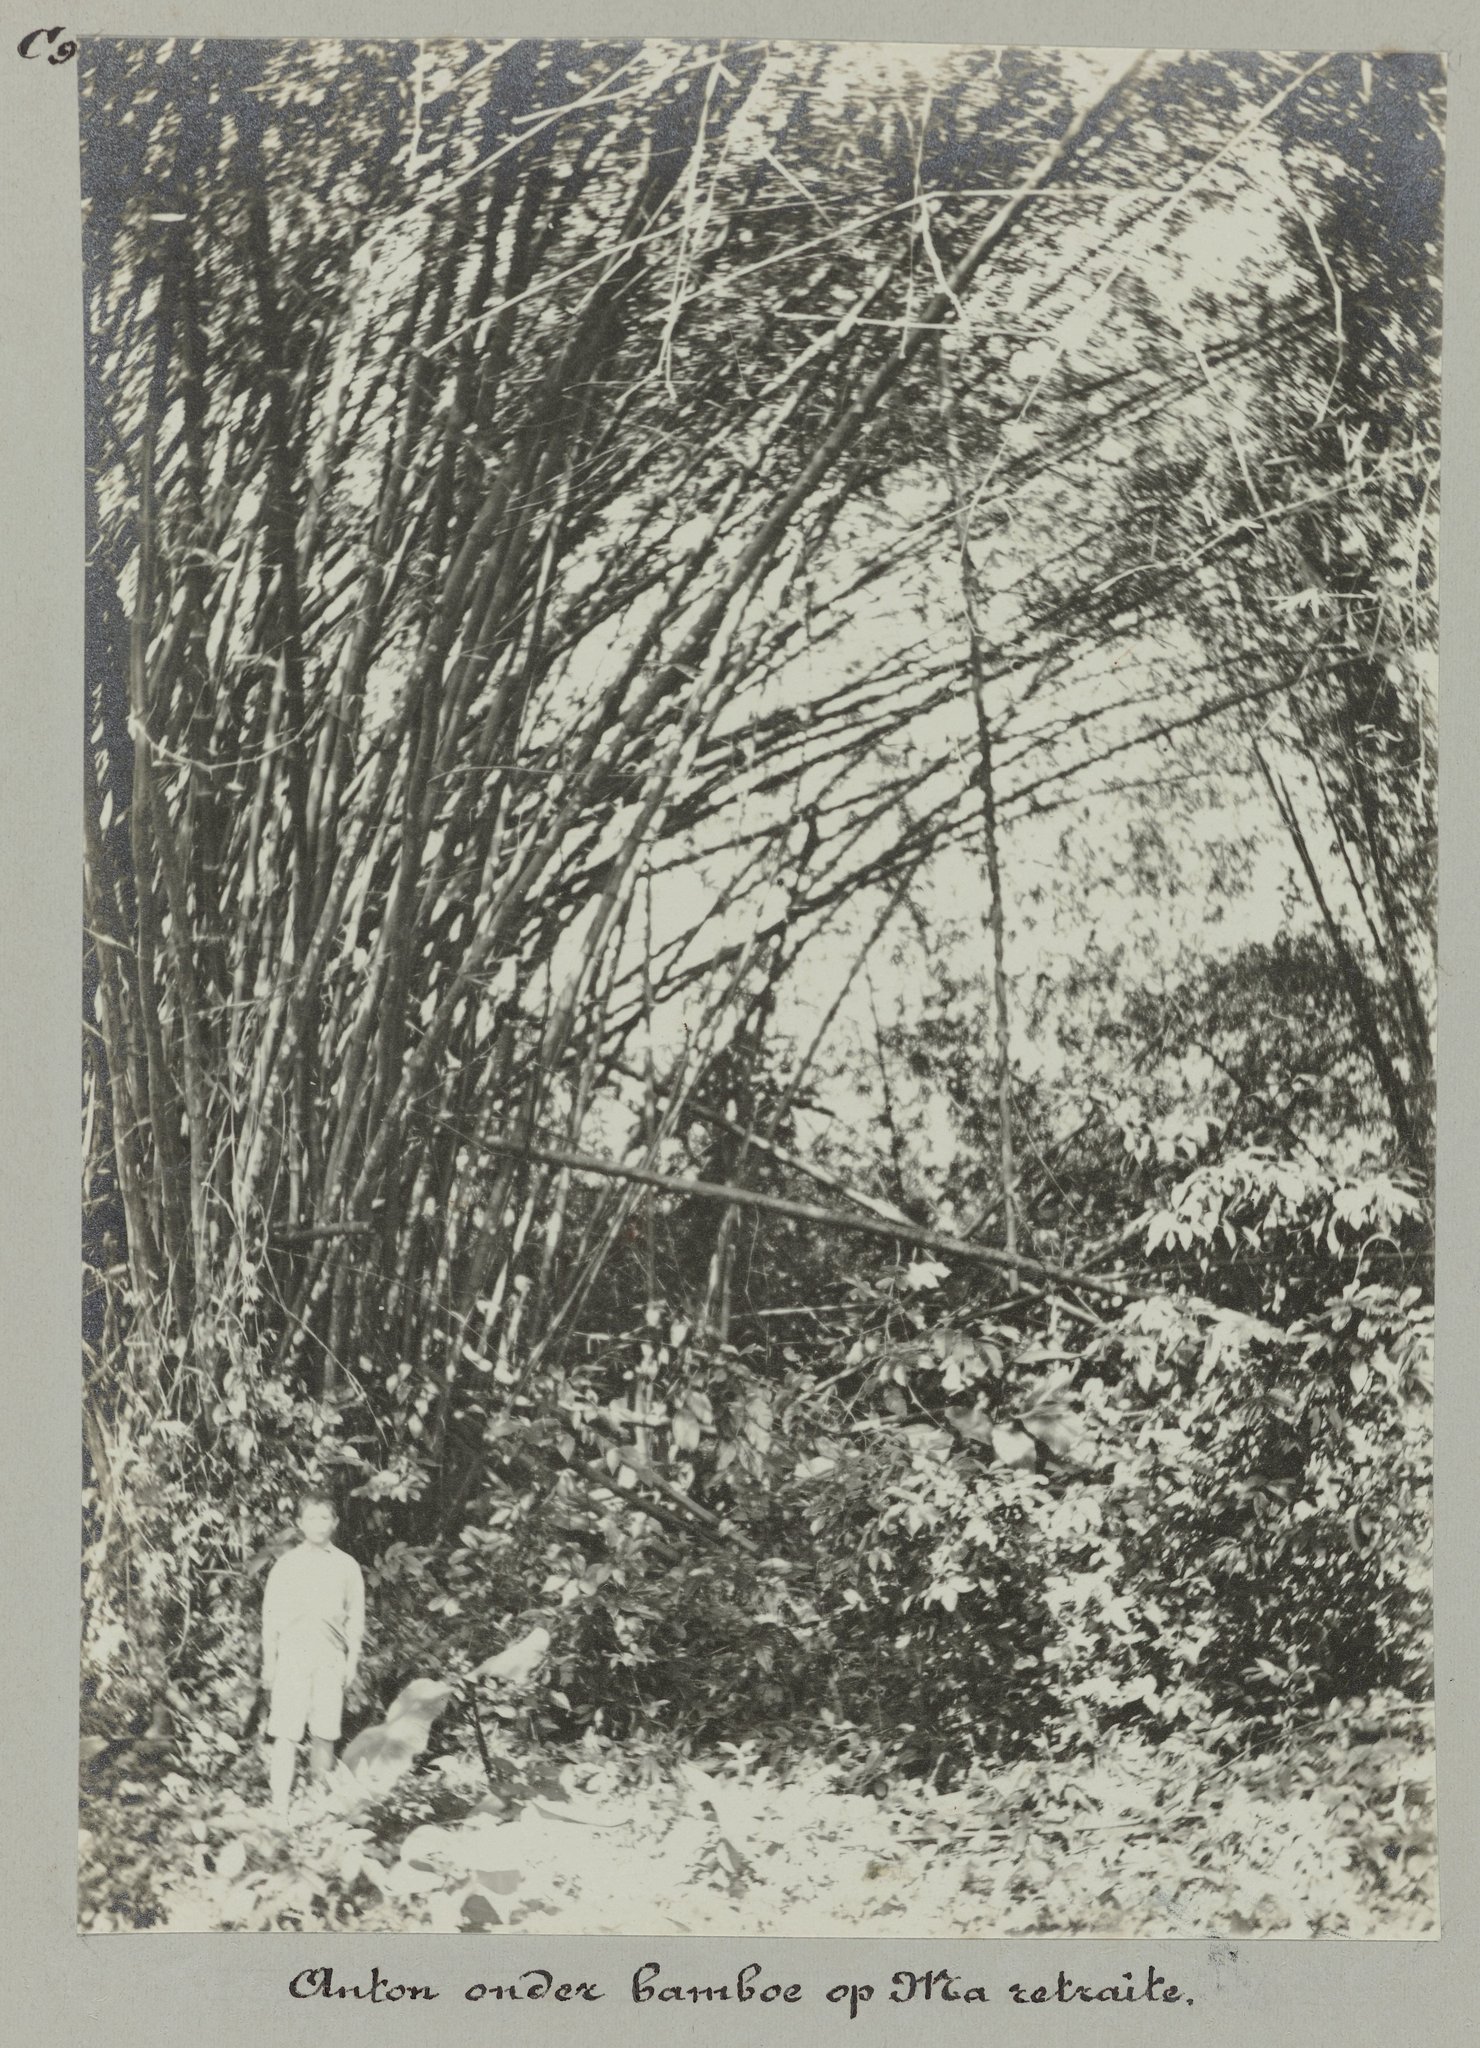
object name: photograph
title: Anton onder bamboe op Ma retraite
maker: hendrik doijer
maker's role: engineer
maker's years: 1863-1925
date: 1903-1910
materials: photographic support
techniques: gelatin silver print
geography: suriname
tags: suriname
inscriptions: inscription: ‘C9 / Anton onder bamboe op Ma retraite.’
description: De Nederlandse jongen genaamd Anton poserend onder hoge bamboetakken op de plantage Ma Retraite. Onderdeel van het fotoalbum Souvenir de Voyage (deel 2), over het leven van de familie Doijer in en rond de plantage Ma Retraite in Suriname in de jaren 1903-1910.